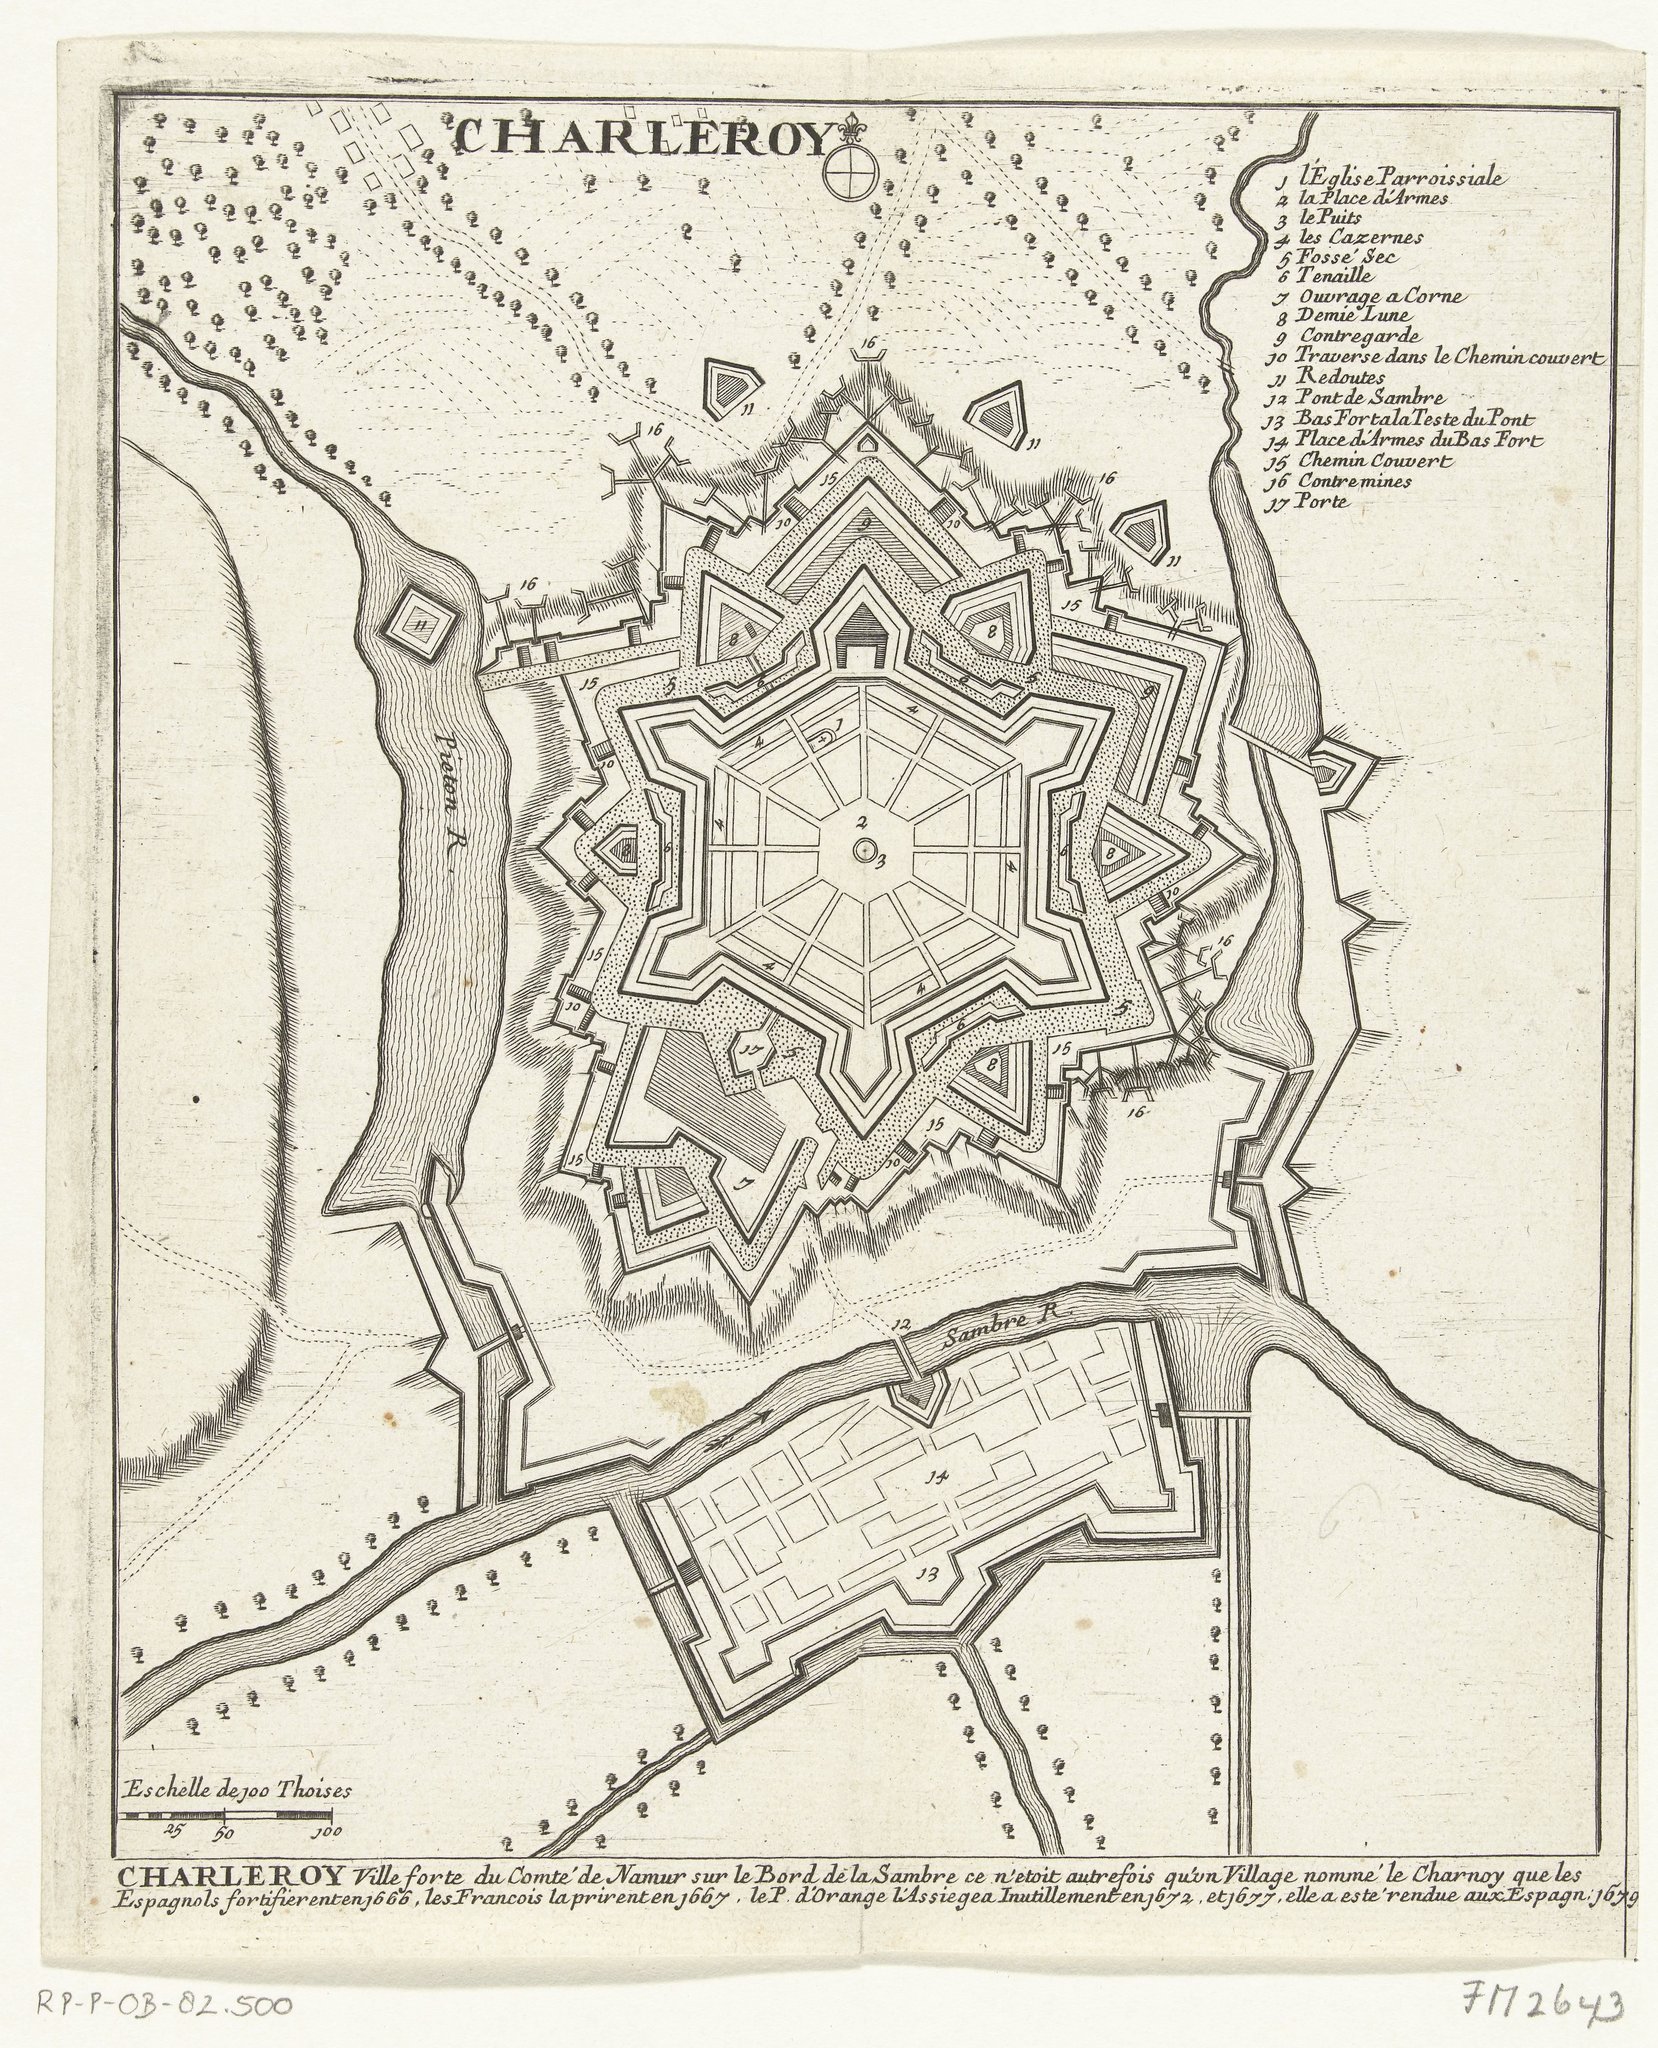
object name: print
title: Plattegrond van Charleroi, 1679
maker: Anonymous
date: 1679-1699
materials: paper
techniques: engraving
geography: france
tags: maps of cities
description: Plattegrond van Charleroi met versterkingen, in 1679 volgens de bepalingen van de Vrede van Nijmegen teruggegeven aan Spanje. Rechtsboven de legenda 1-17 in het Frans.